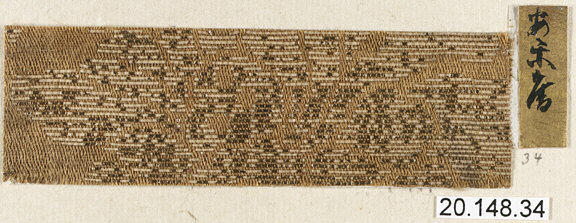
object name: piece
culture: japanese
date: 1401-1500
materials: silk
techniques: compound weave